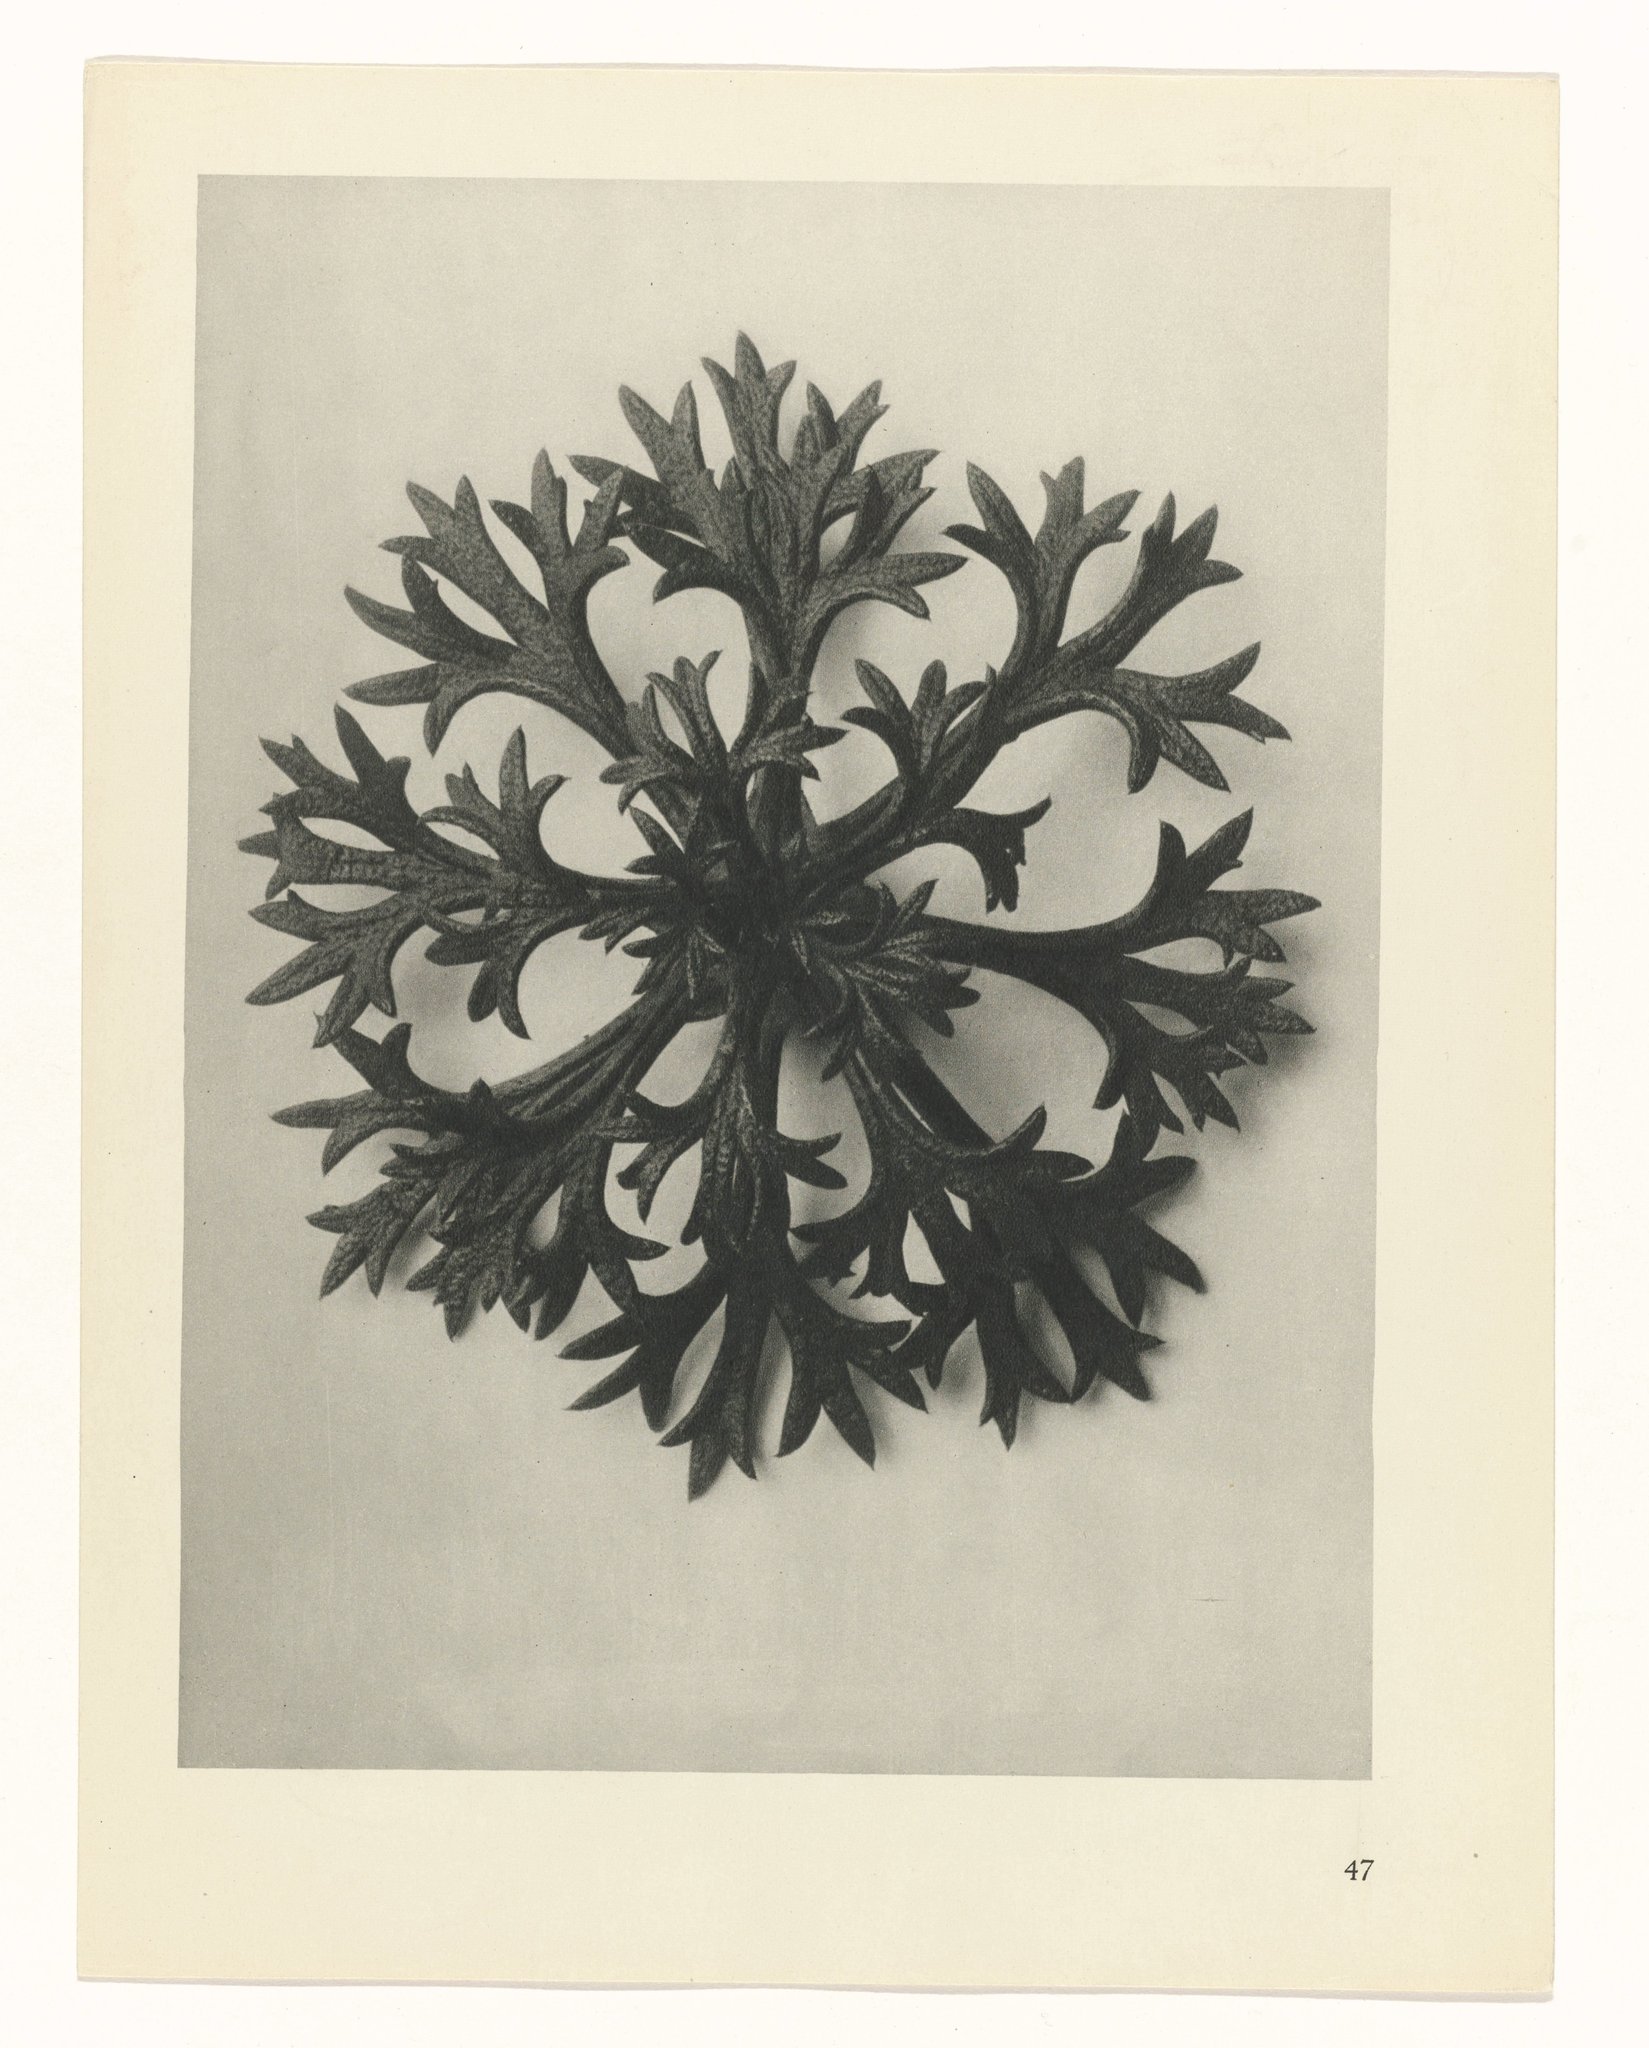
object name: photograph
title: Urformen der Kunst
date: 1928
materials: ink, paper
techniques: rotogravure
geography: berlin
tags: plants (in general)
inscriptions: number: ‘47’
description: facher Vergrößerung. Afkomstig uit losbladige uitgave.